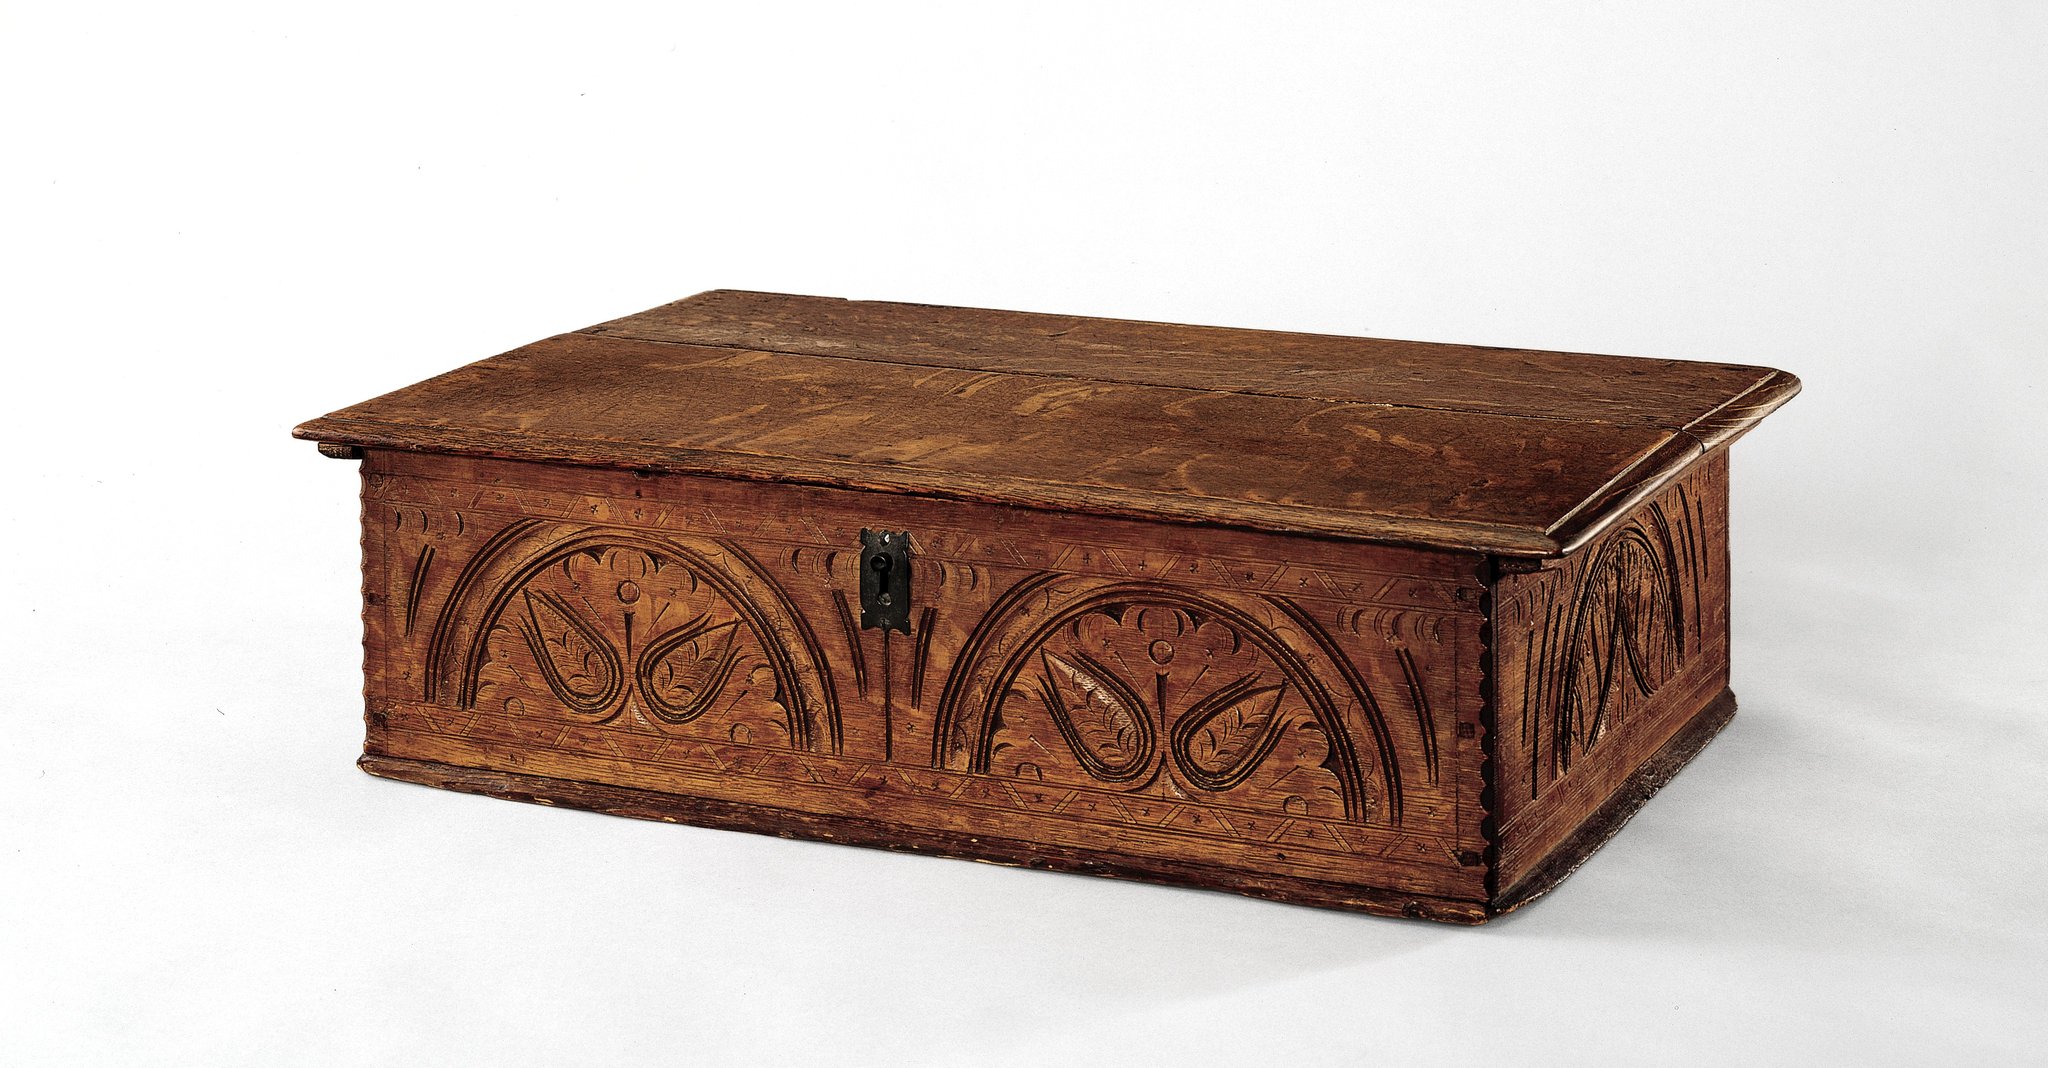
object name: box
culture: american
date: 1660-1700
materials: wood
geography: united states